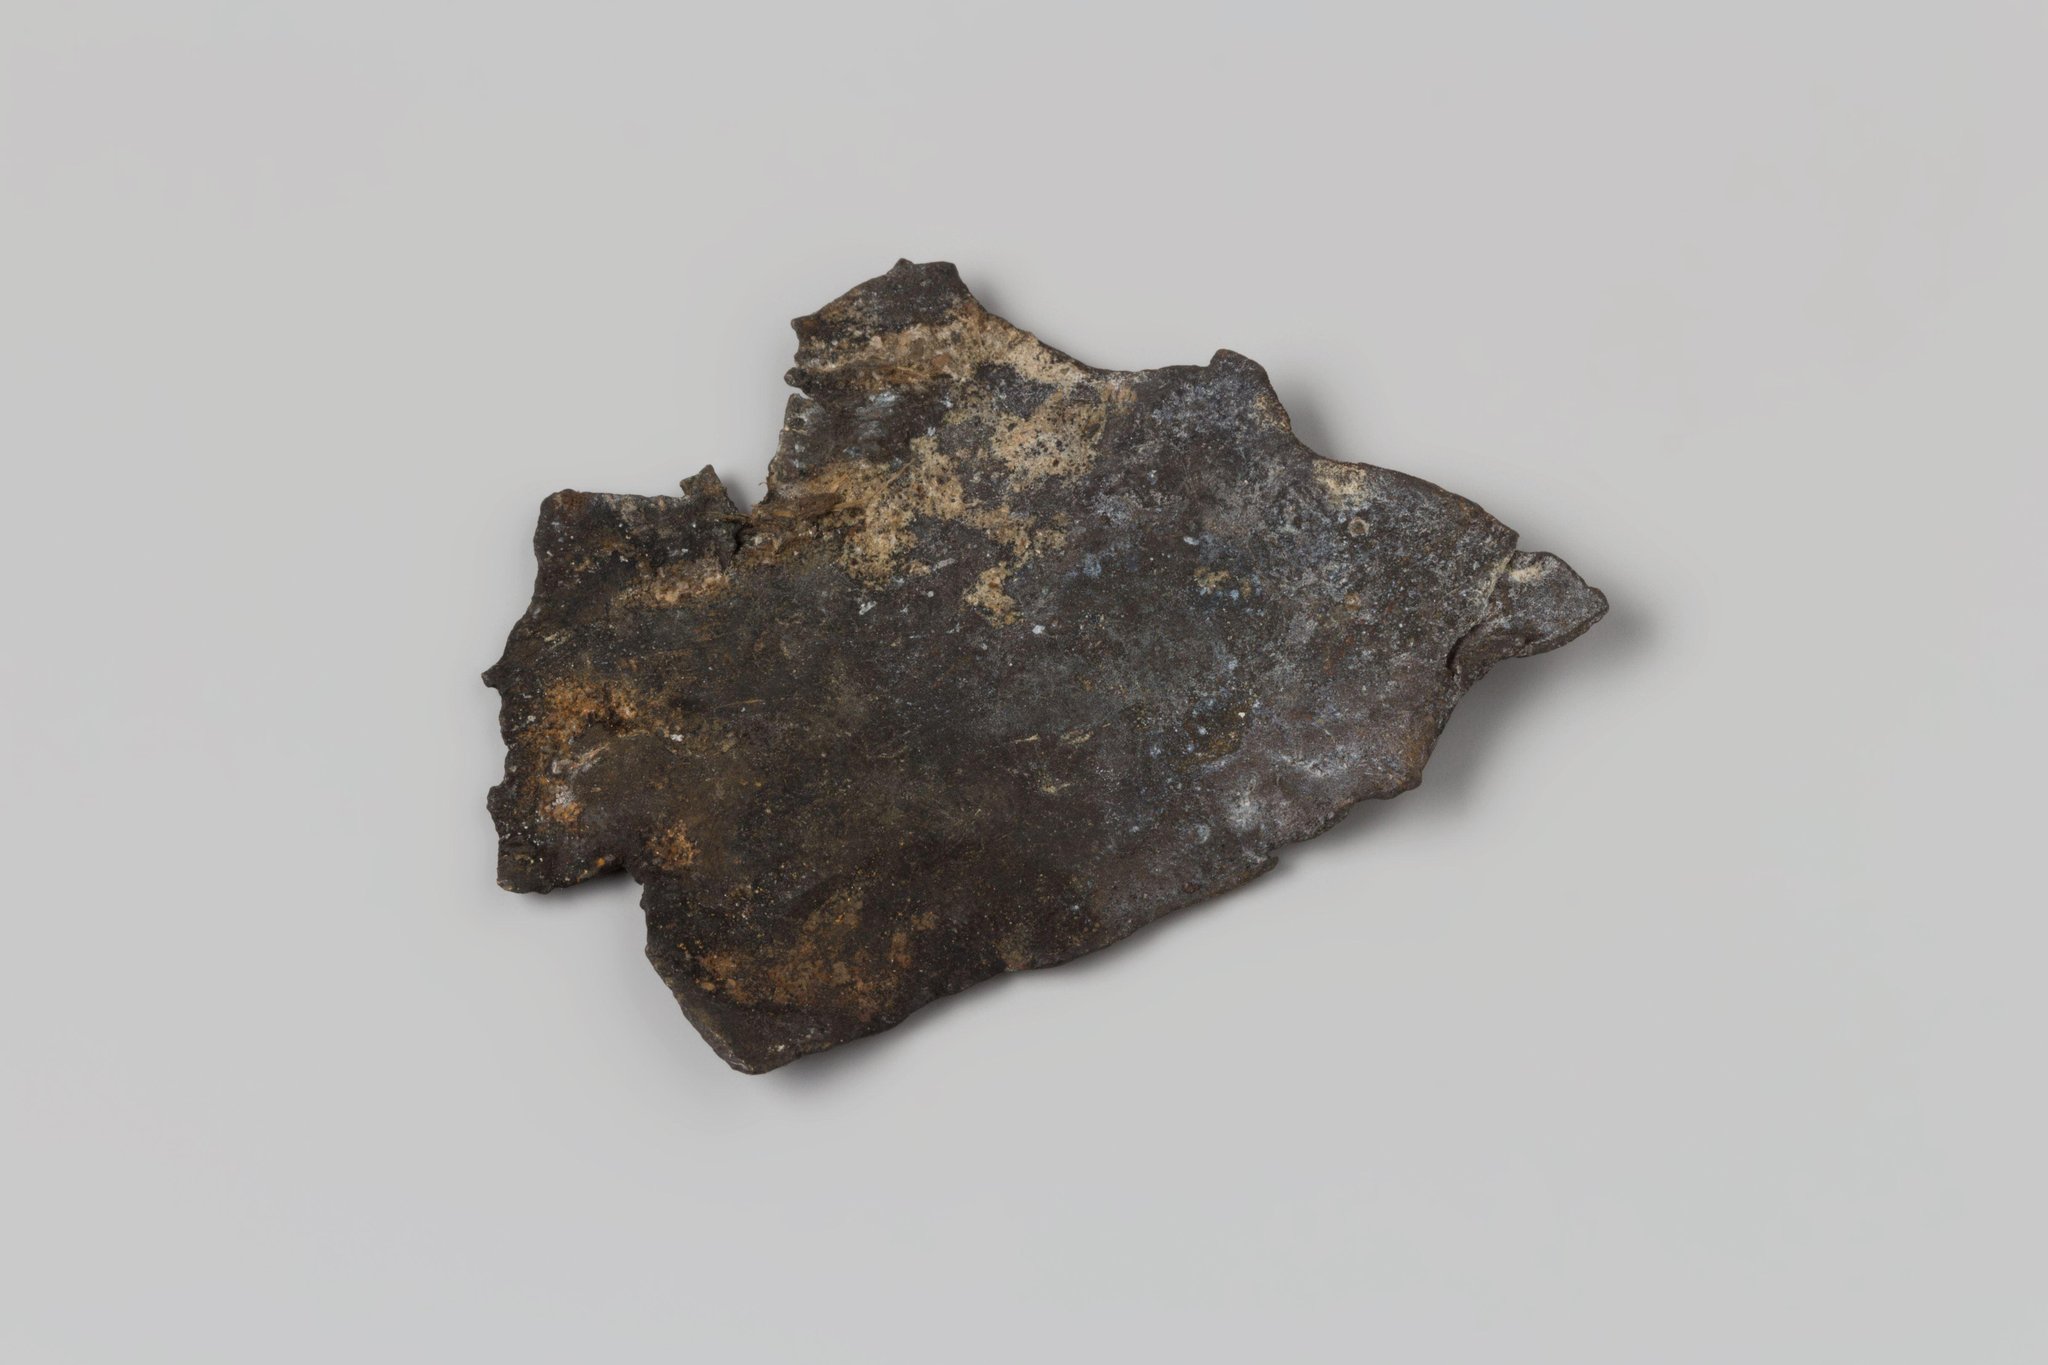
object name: scheepswrakvondst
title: Fragment van koper uit het wrak van de Oost-Indiëvaarder Hollandia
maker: Anonymous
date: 1700-1743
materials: copper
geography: netherlands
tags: verenigde oostindische compagnie, hollandia (schip), annet